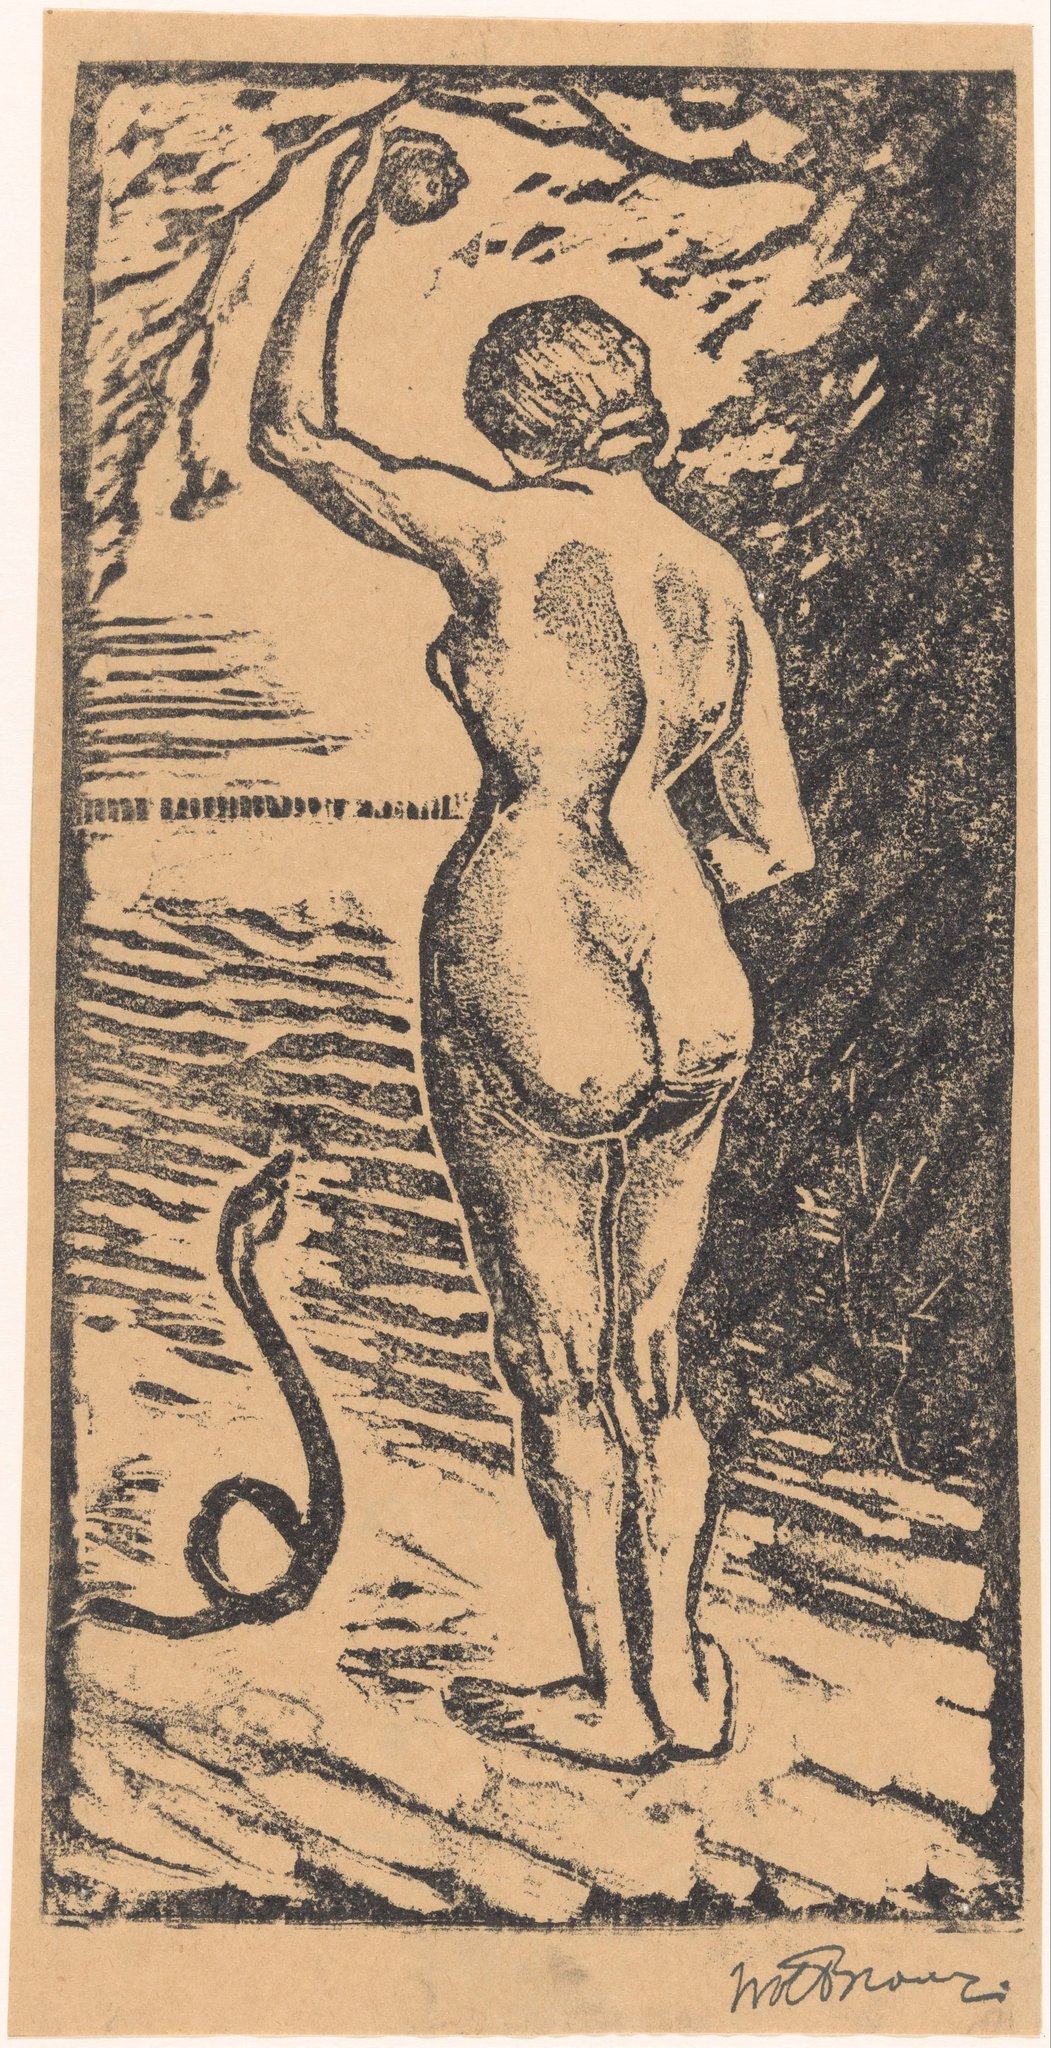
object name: print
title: Eva en de slang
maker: wolbartus brouwer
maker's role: print maker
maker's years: 1880-1933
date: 1890-1933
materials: paper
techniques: lithograph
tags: the serpent tries to persuade eve to take some of the fruit (usually an apple)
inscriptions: collector's mark: Lugt 2760, collector's mark: Lugt 2228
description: Eva plukt een vrucht van de boom van de kennis van goed en kwaad. Bij haar voeten de slang.